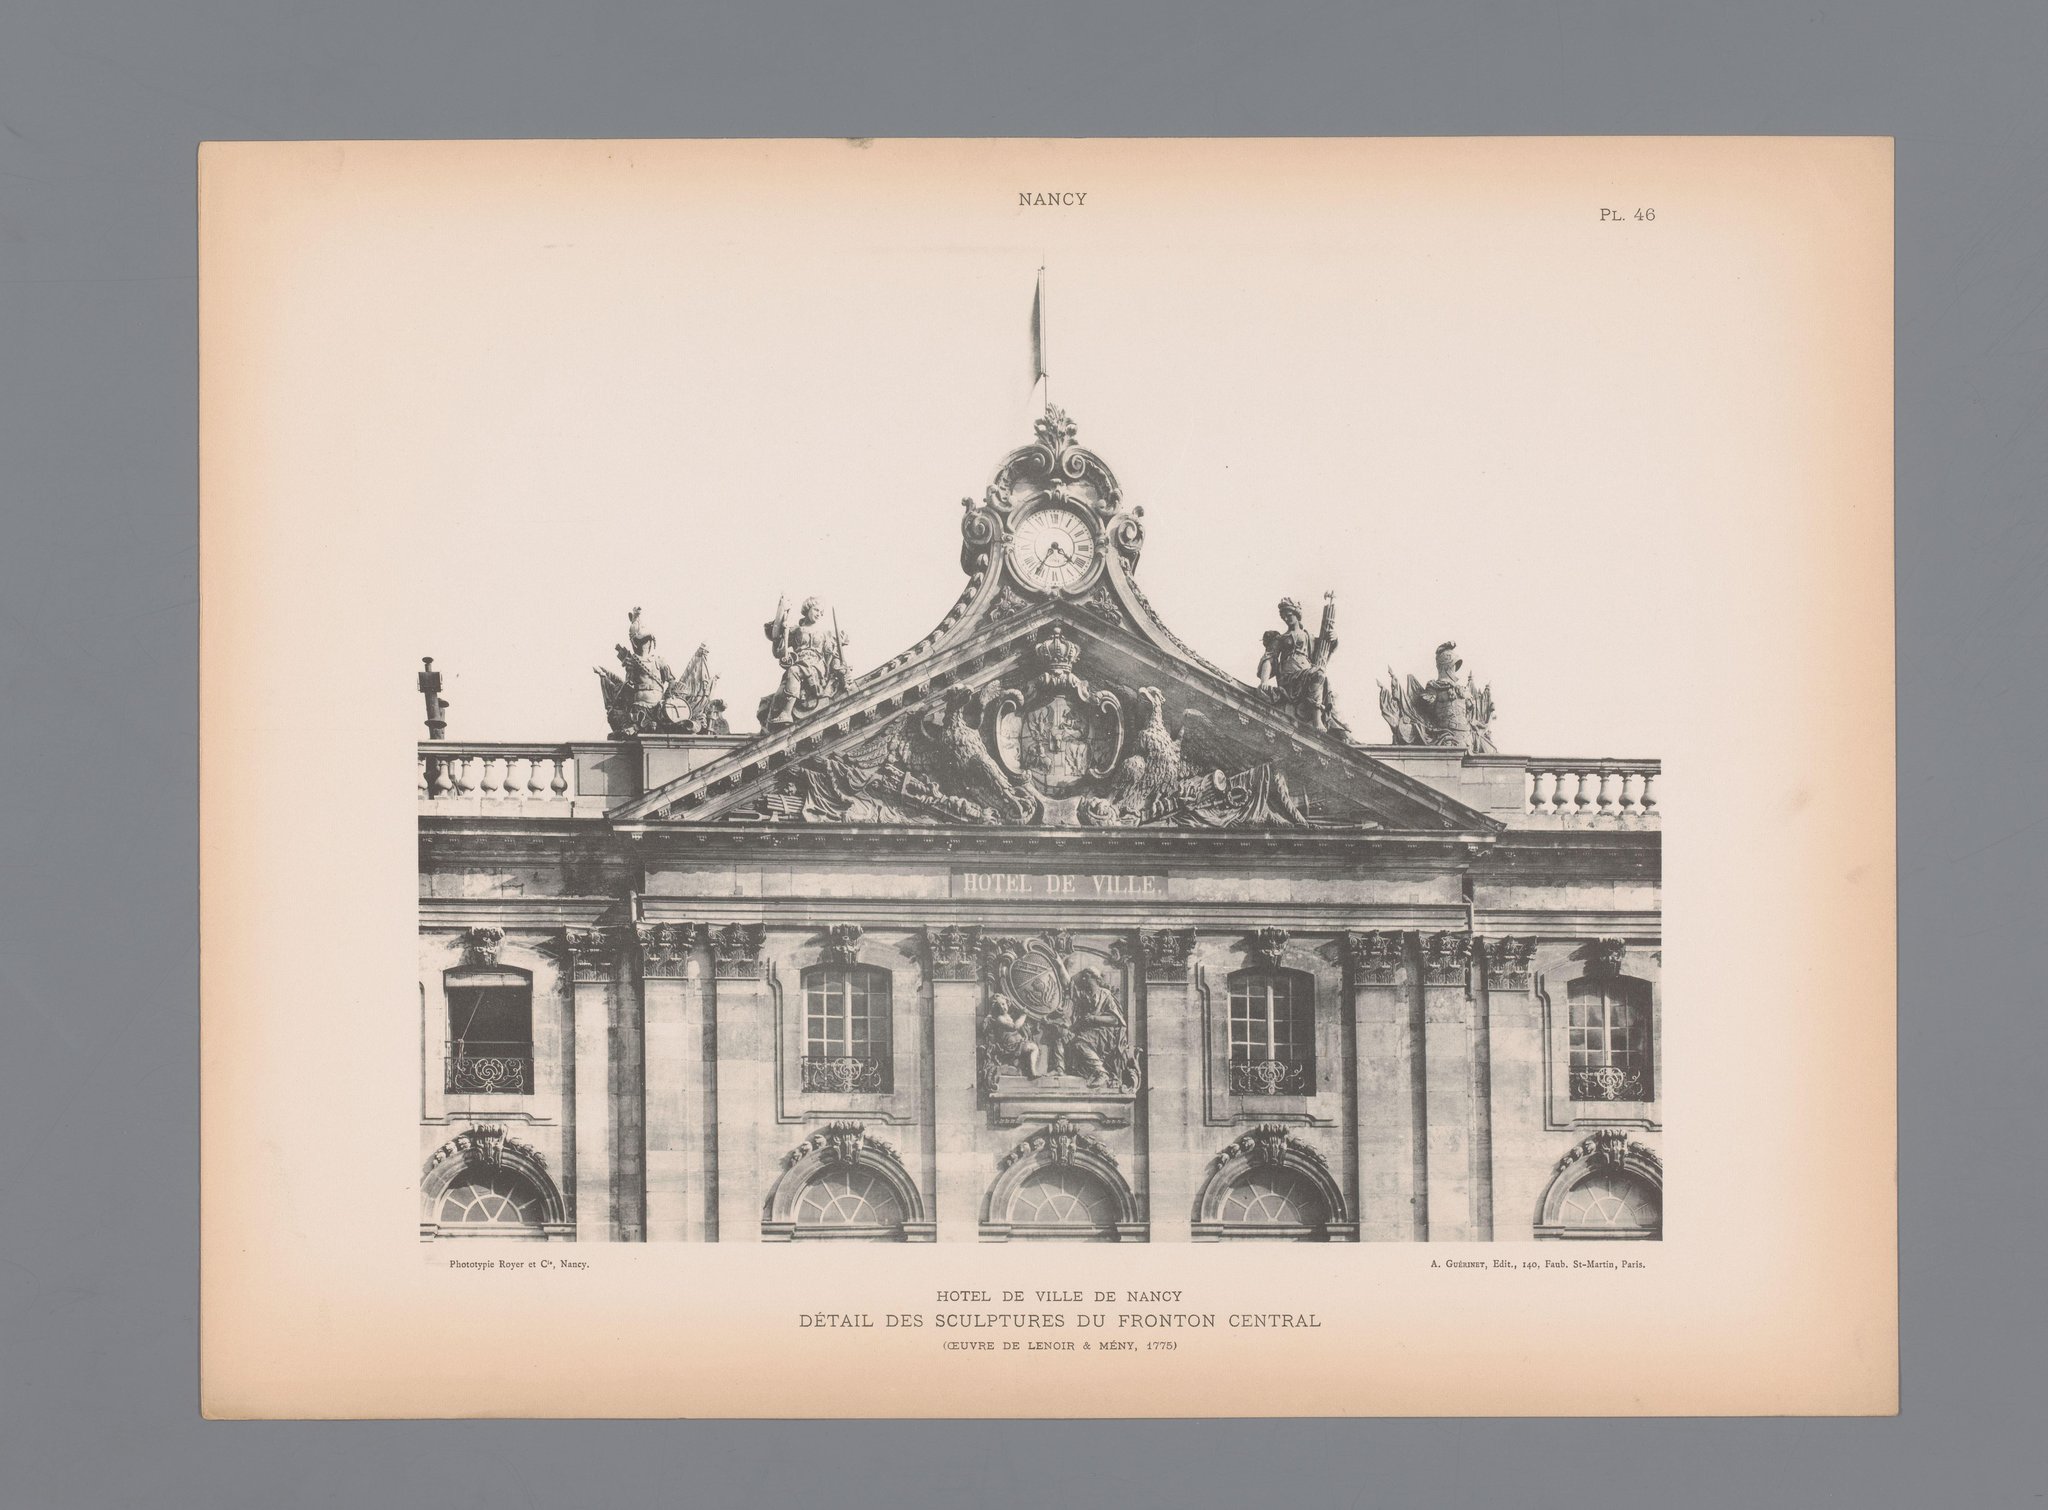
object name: photomechanical print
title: Gevel van het stadhuis van Nancy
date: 1891-1896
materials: paper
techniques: photograph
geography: paris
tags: clock, townhall, sculpture (+ relief ~ sculpture)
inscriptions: inscription: ‘Hotel de ville de Nancy/ Détail des sculptures du ronton central (...)’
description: Deze prent maakt deel uit van een omslag met 103 prenten op 101 bladen en een titelblad.